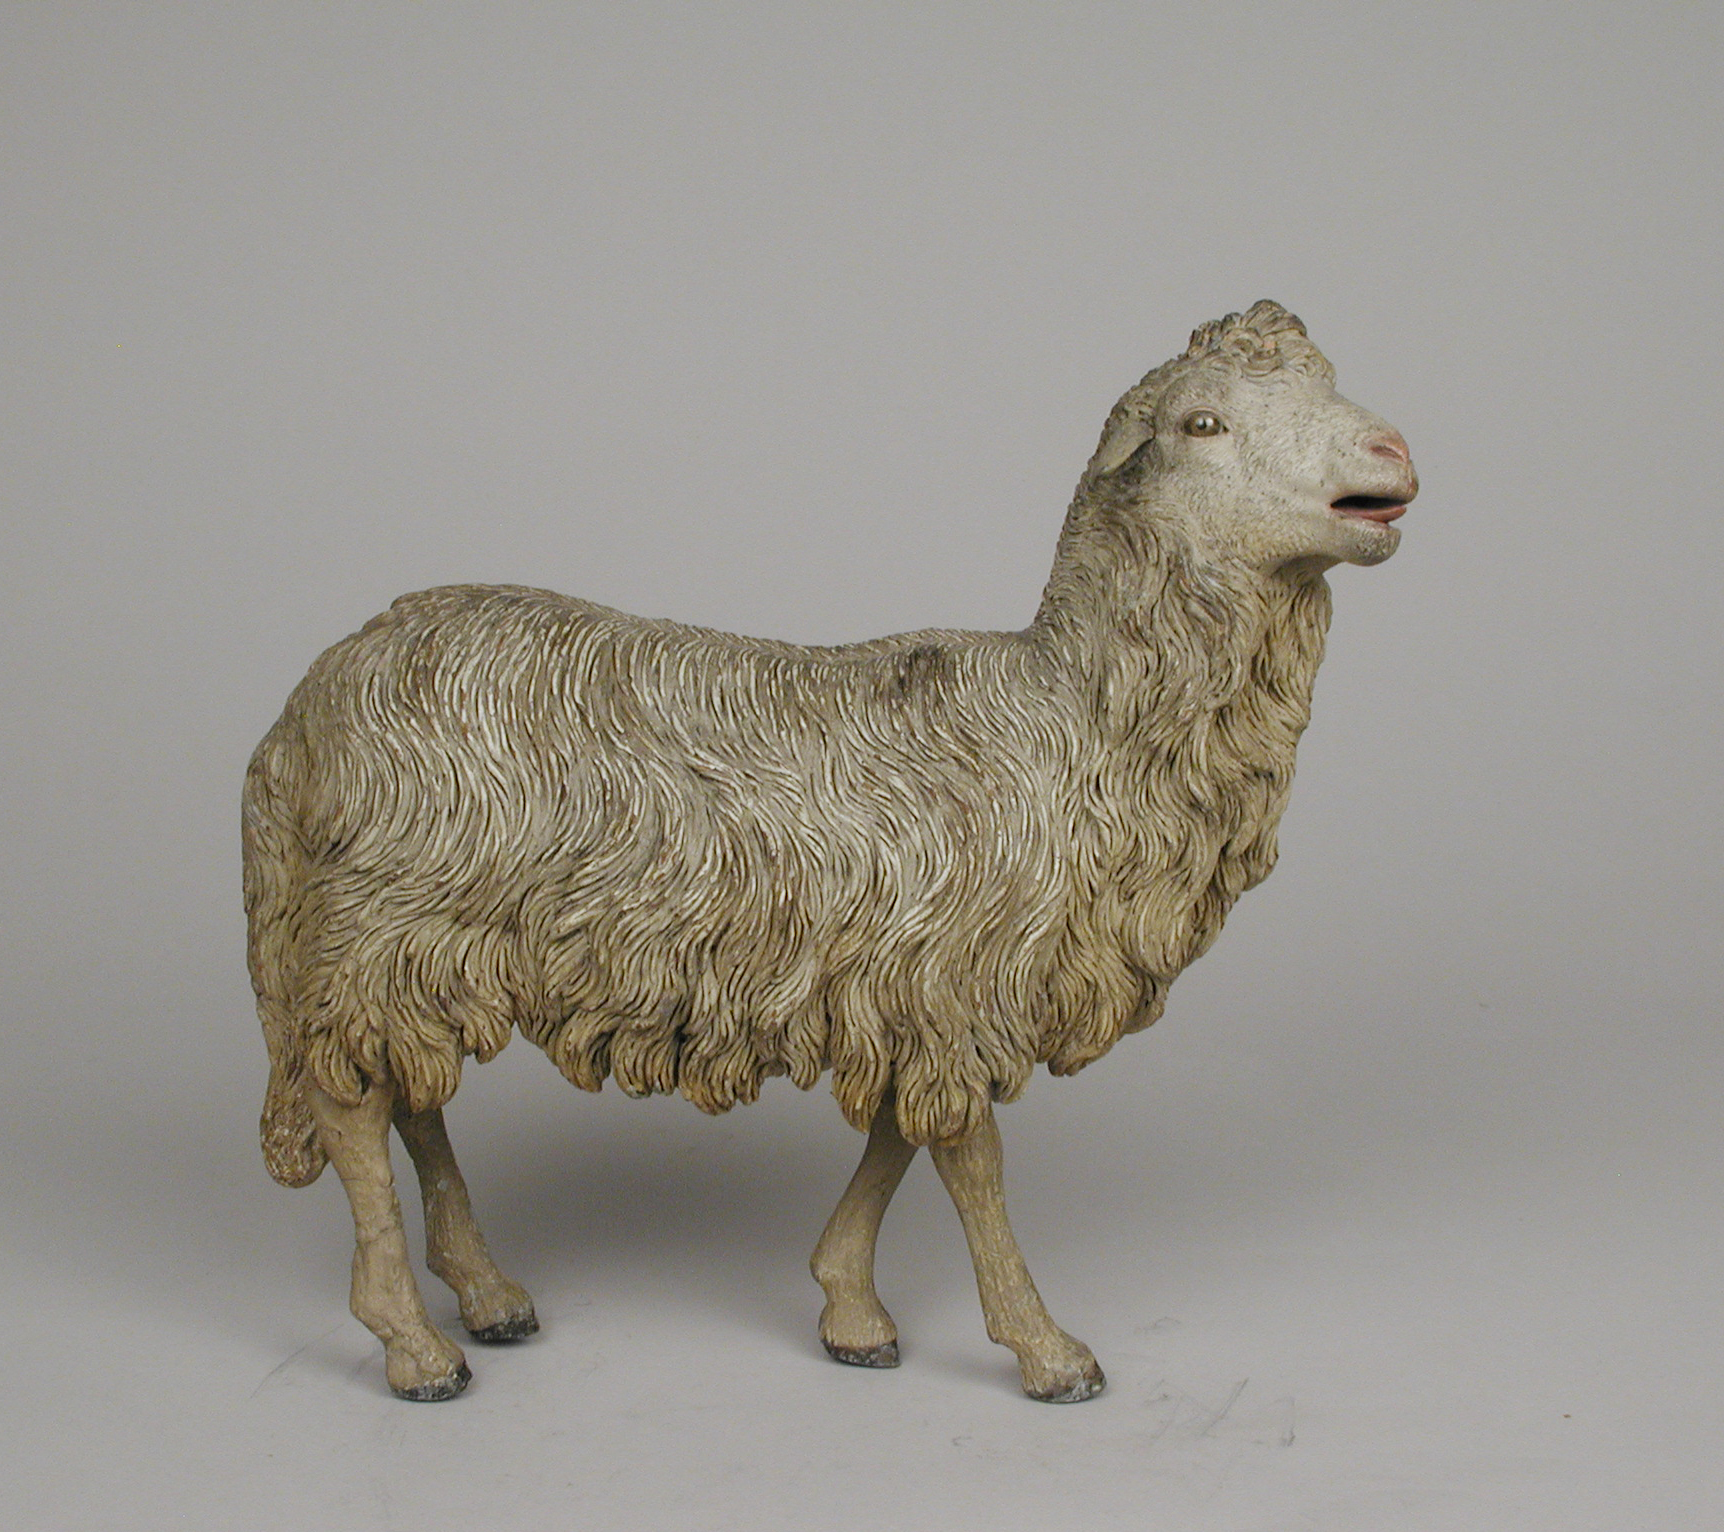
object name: crèche figure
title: Standing sheep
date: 1751-1800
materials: lead, terracotta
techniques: polychrome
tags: sheep